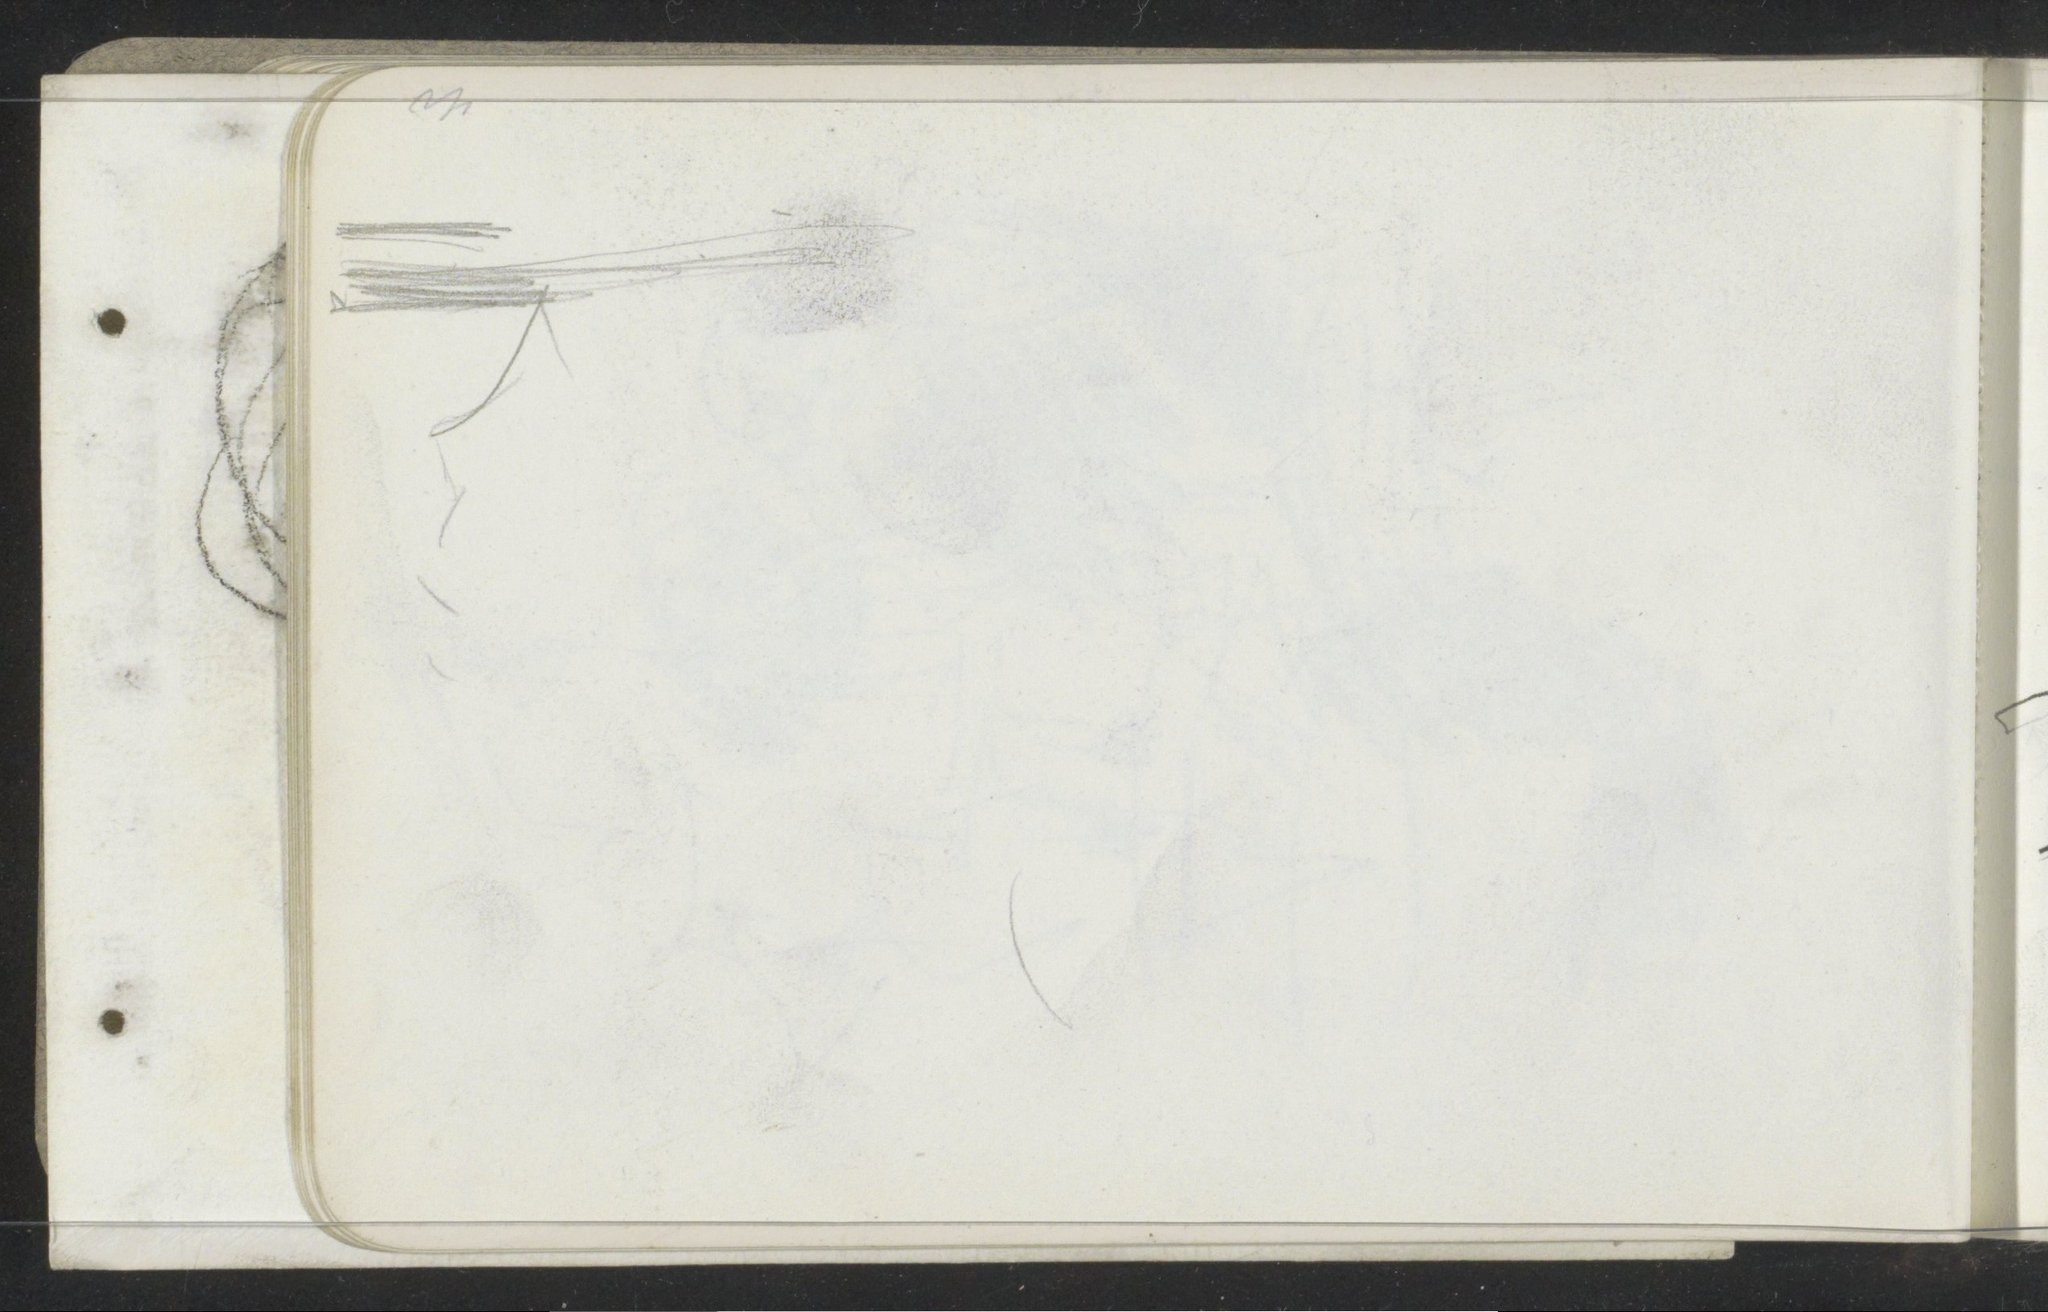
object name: sketchbook leaf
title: Studie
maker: isaac israels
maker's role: draughtsman, painter, print maker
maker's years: 1865-1934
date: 1875-1934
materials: paper, pencil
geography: the hague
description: Blad 27 verso uit schetsboek LX met 33 bladen.